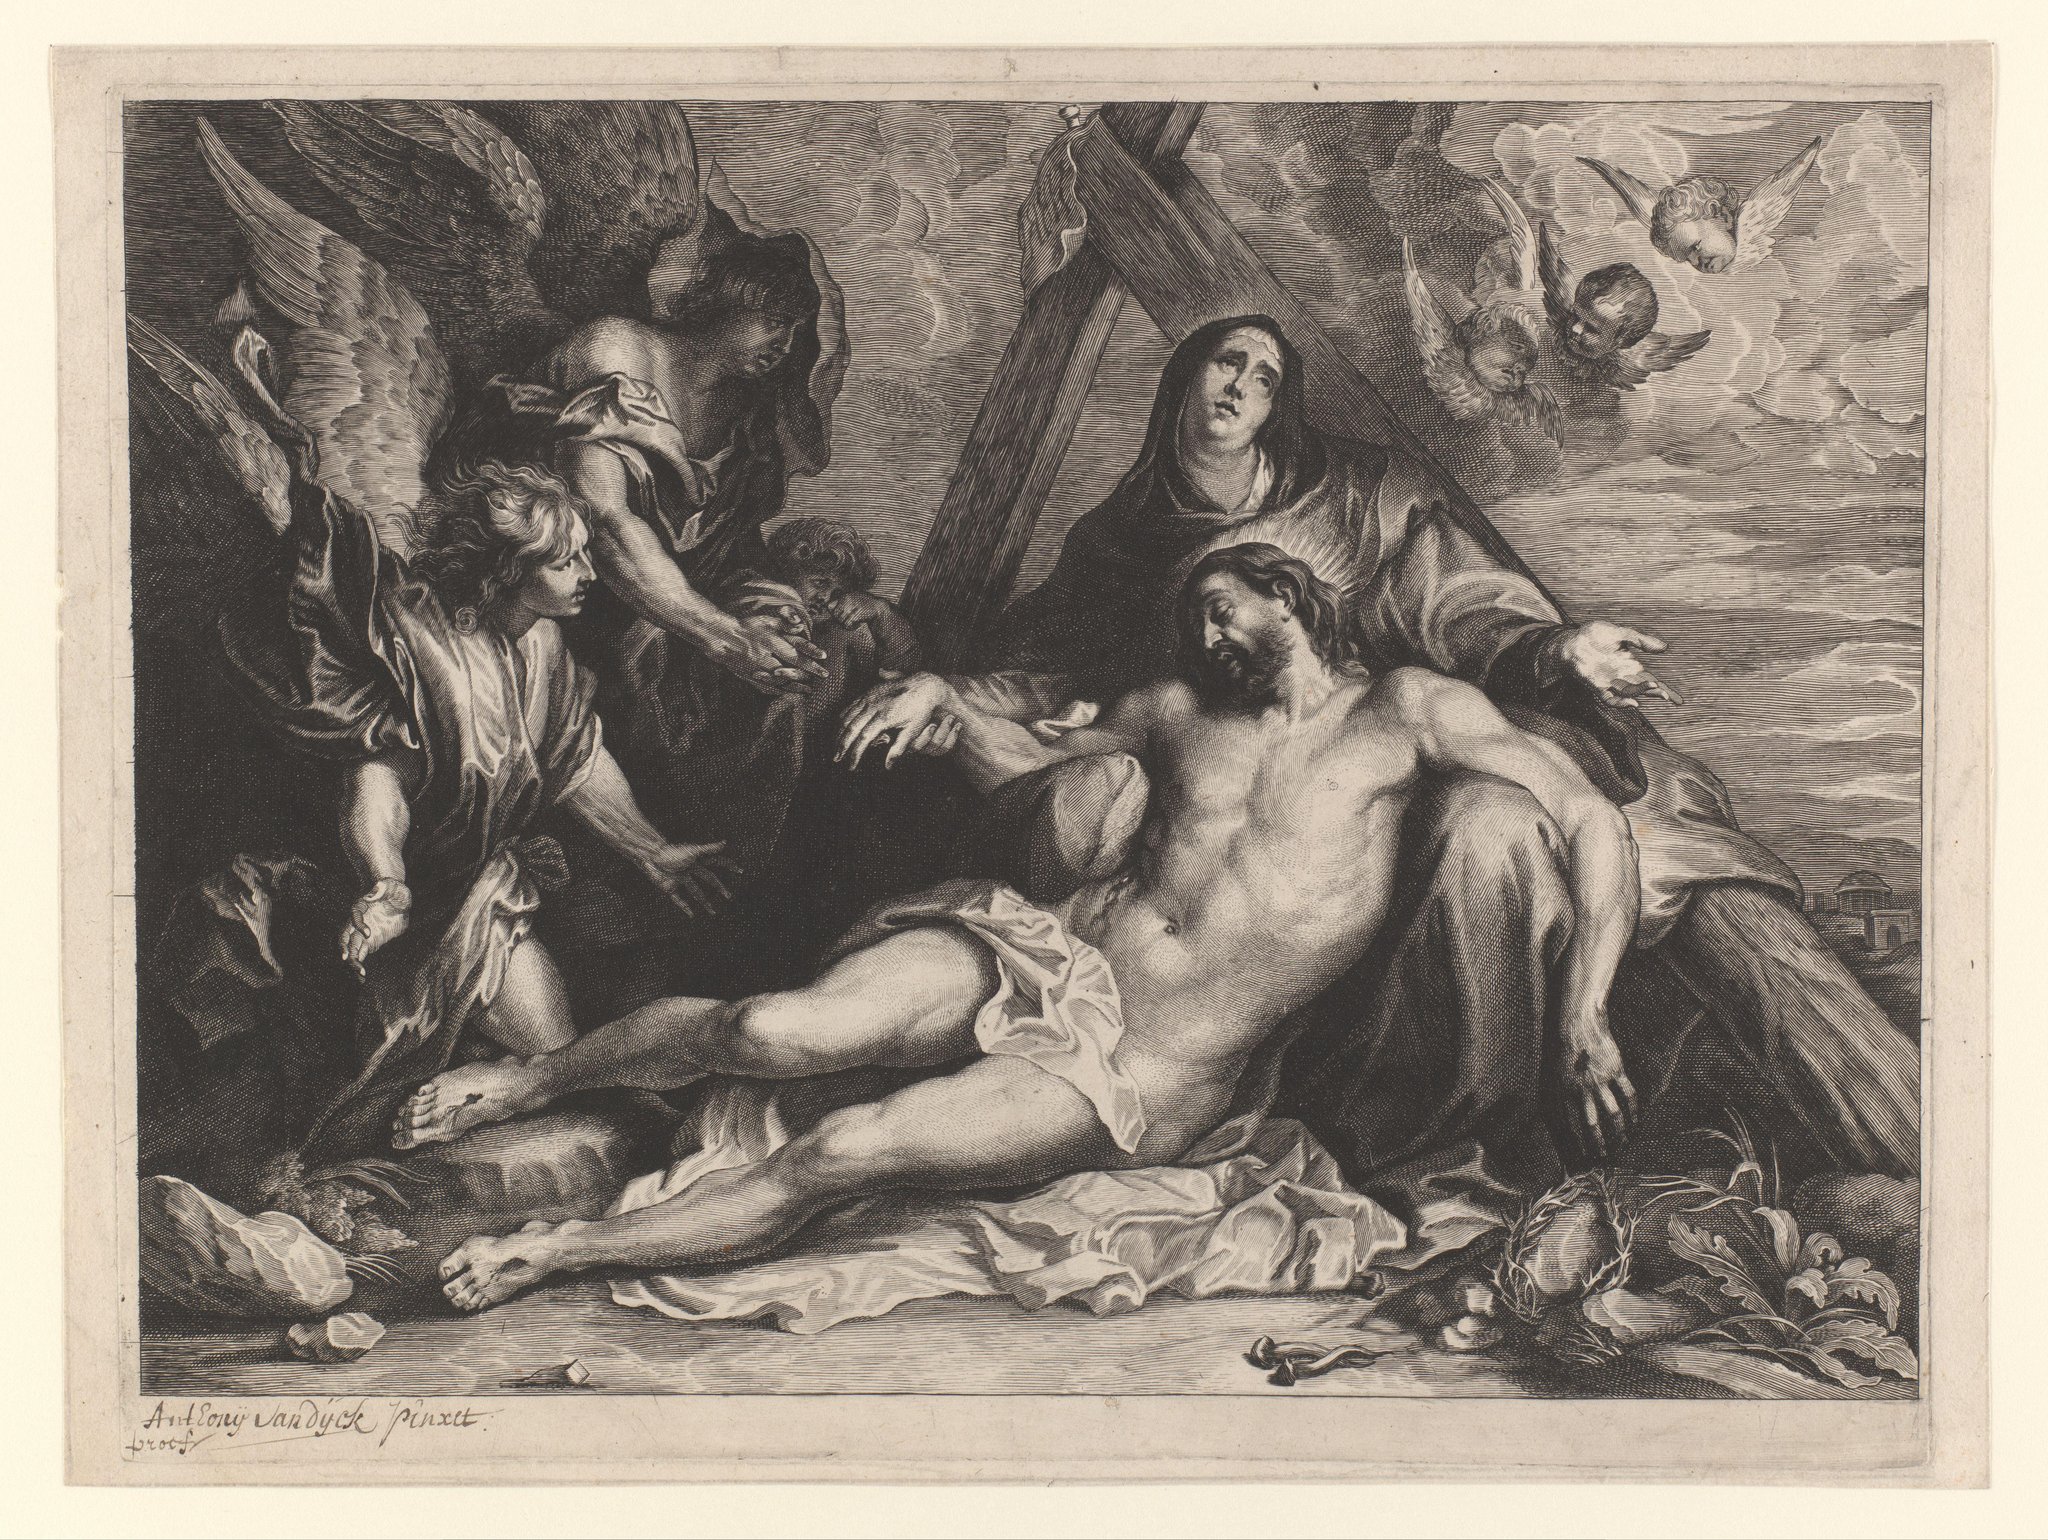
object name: print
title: Bewening van Christus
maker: Anonymous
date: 1634-1684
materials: paper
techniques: engraving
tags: the mourning over the dead christ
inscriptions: collector's mark: Lugt 240, inscription: ‘Anthonij van dijck pinxit/ proof’